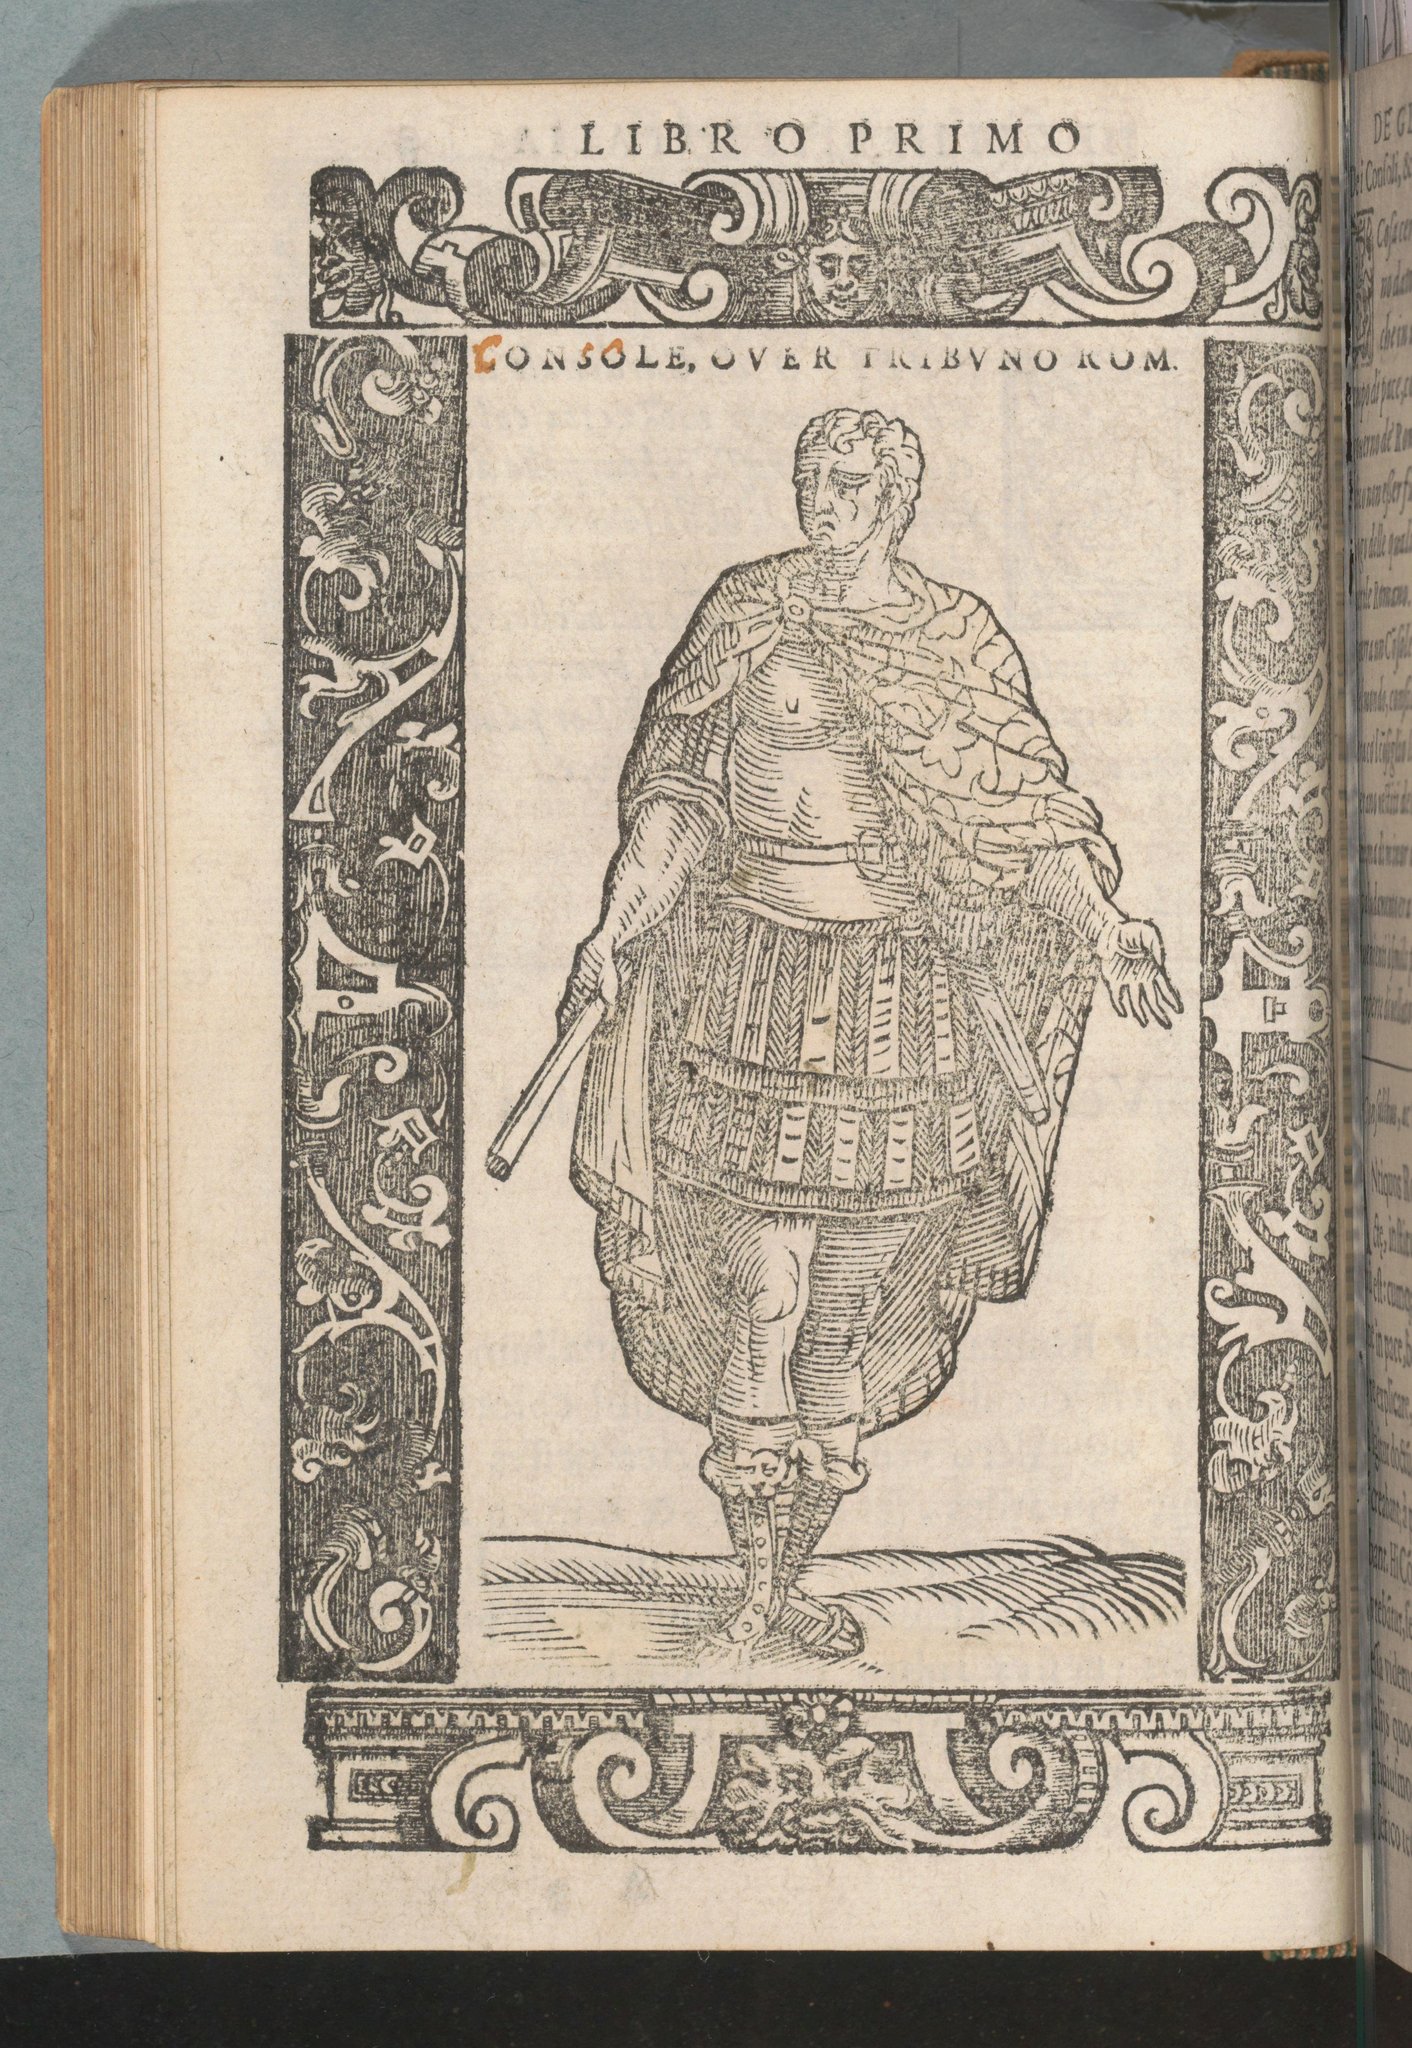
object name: costume print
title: Habiti antichi, et moderni di tutto il mondo : di nuovo accresciuti di molte figure : vestitus antiquorum, recentiorumque totius orbis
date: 1598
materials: paper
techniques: woodcut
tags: other sovereign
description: Romeins consul in kuras, waarover een schoudermantel (popora) . Half hoge laarzen waaronder kousen van fijne wol.